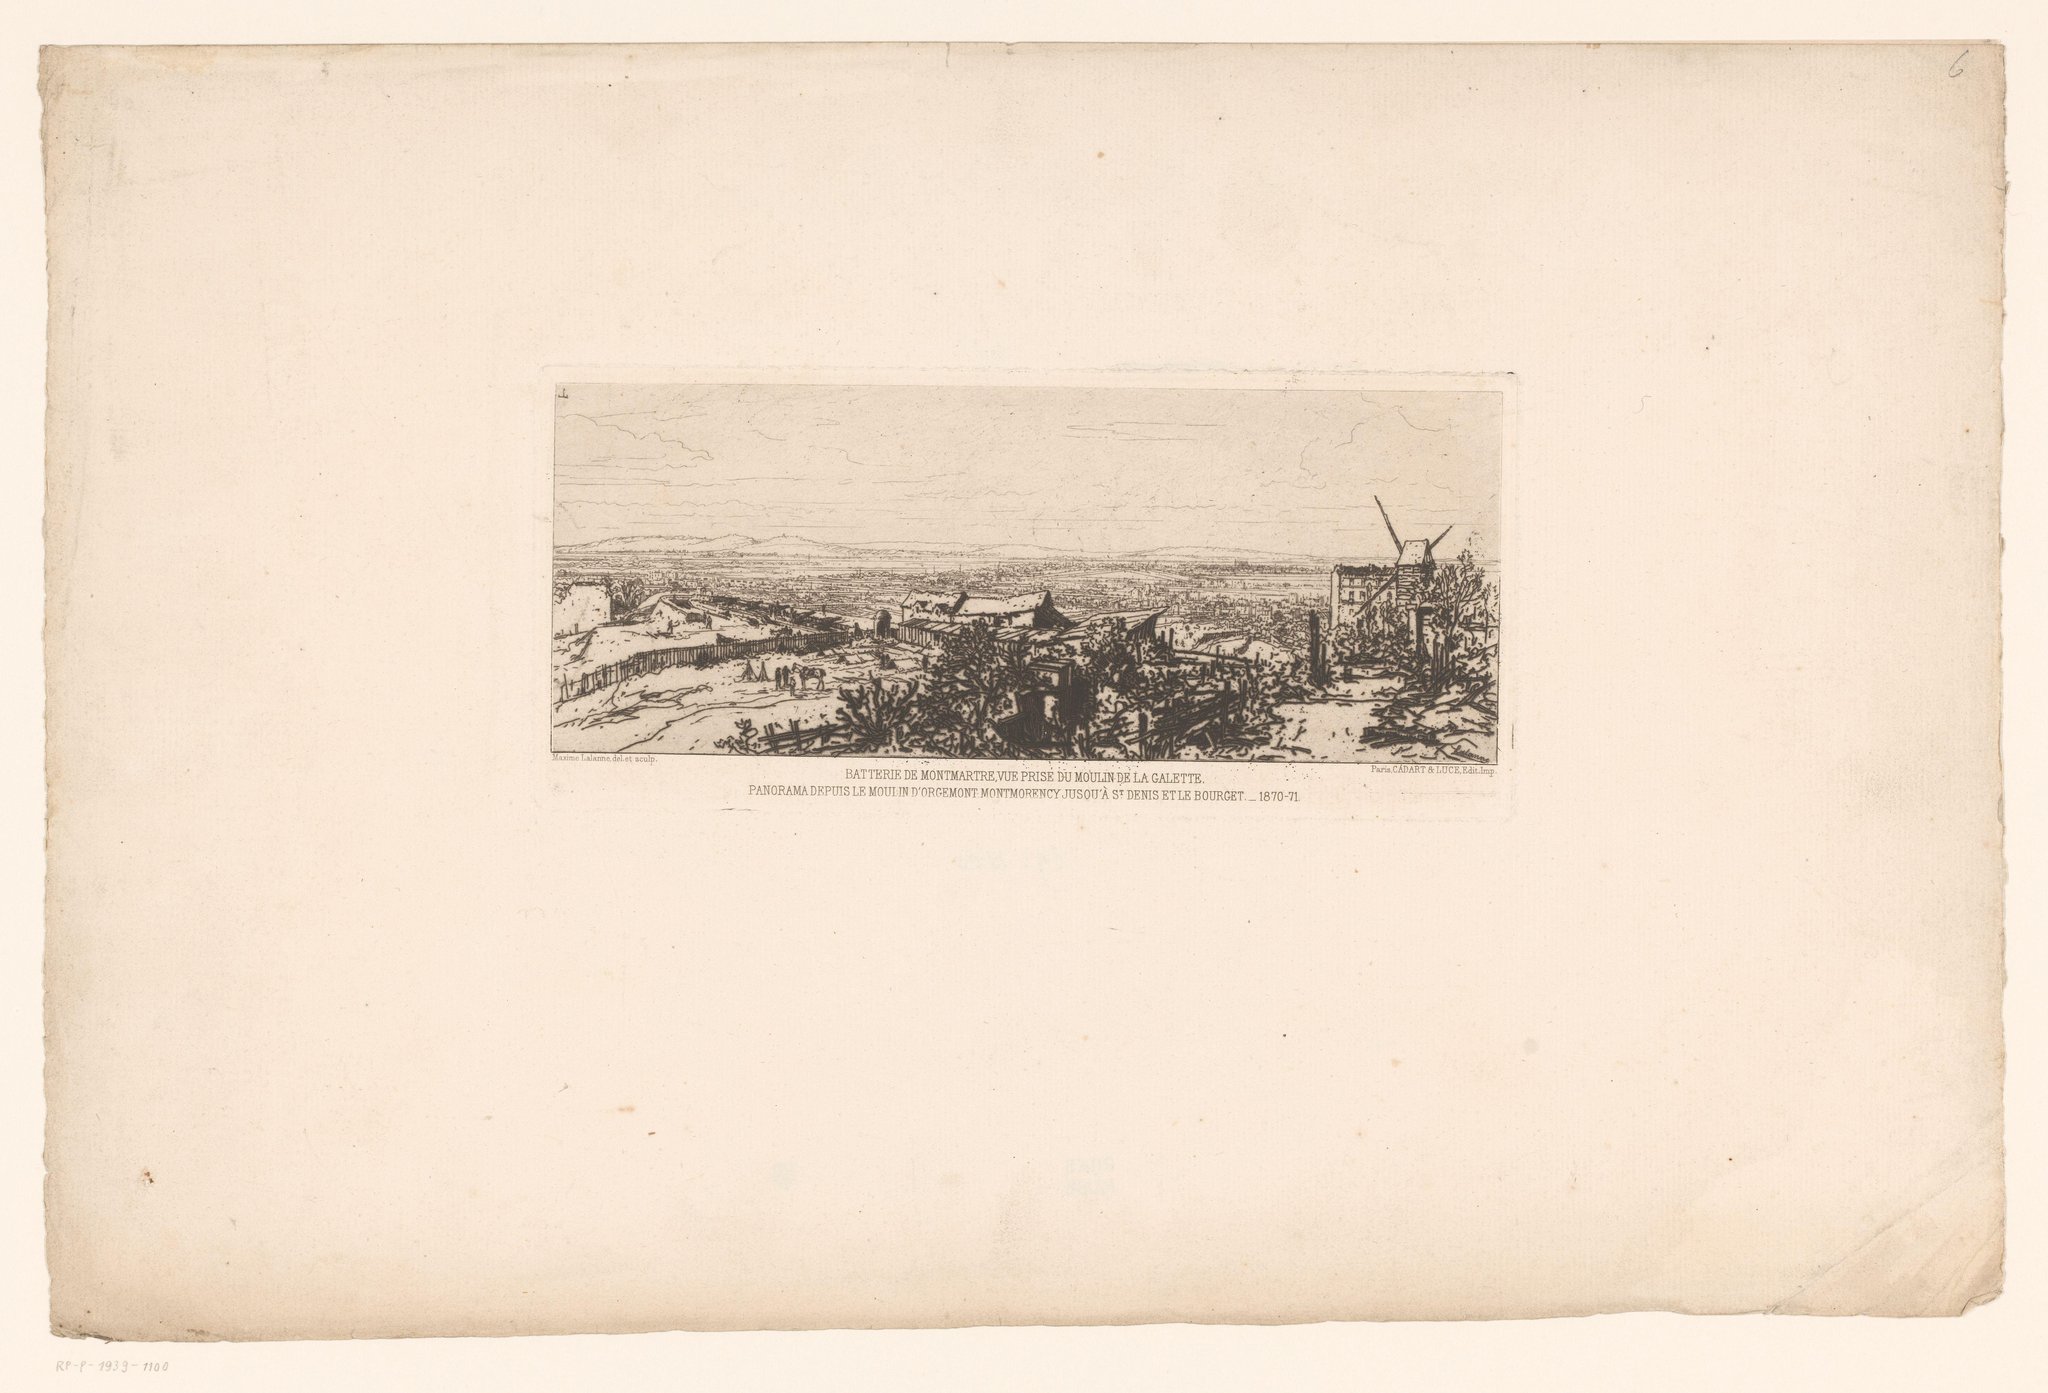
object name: print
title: Souvenirs artistiques du siège de Paris, 1870-1871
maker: maxime françois antoine lalanne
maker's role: draughtsman, print maker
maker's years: 1827-1886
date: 1871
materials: paper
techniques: drypoint, engraving, etching, intaglio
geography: paris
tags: city-view in general; 'veduta'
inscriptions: collector's mark: Lugt 2760, collector's mark: Lugt 2166, watermark